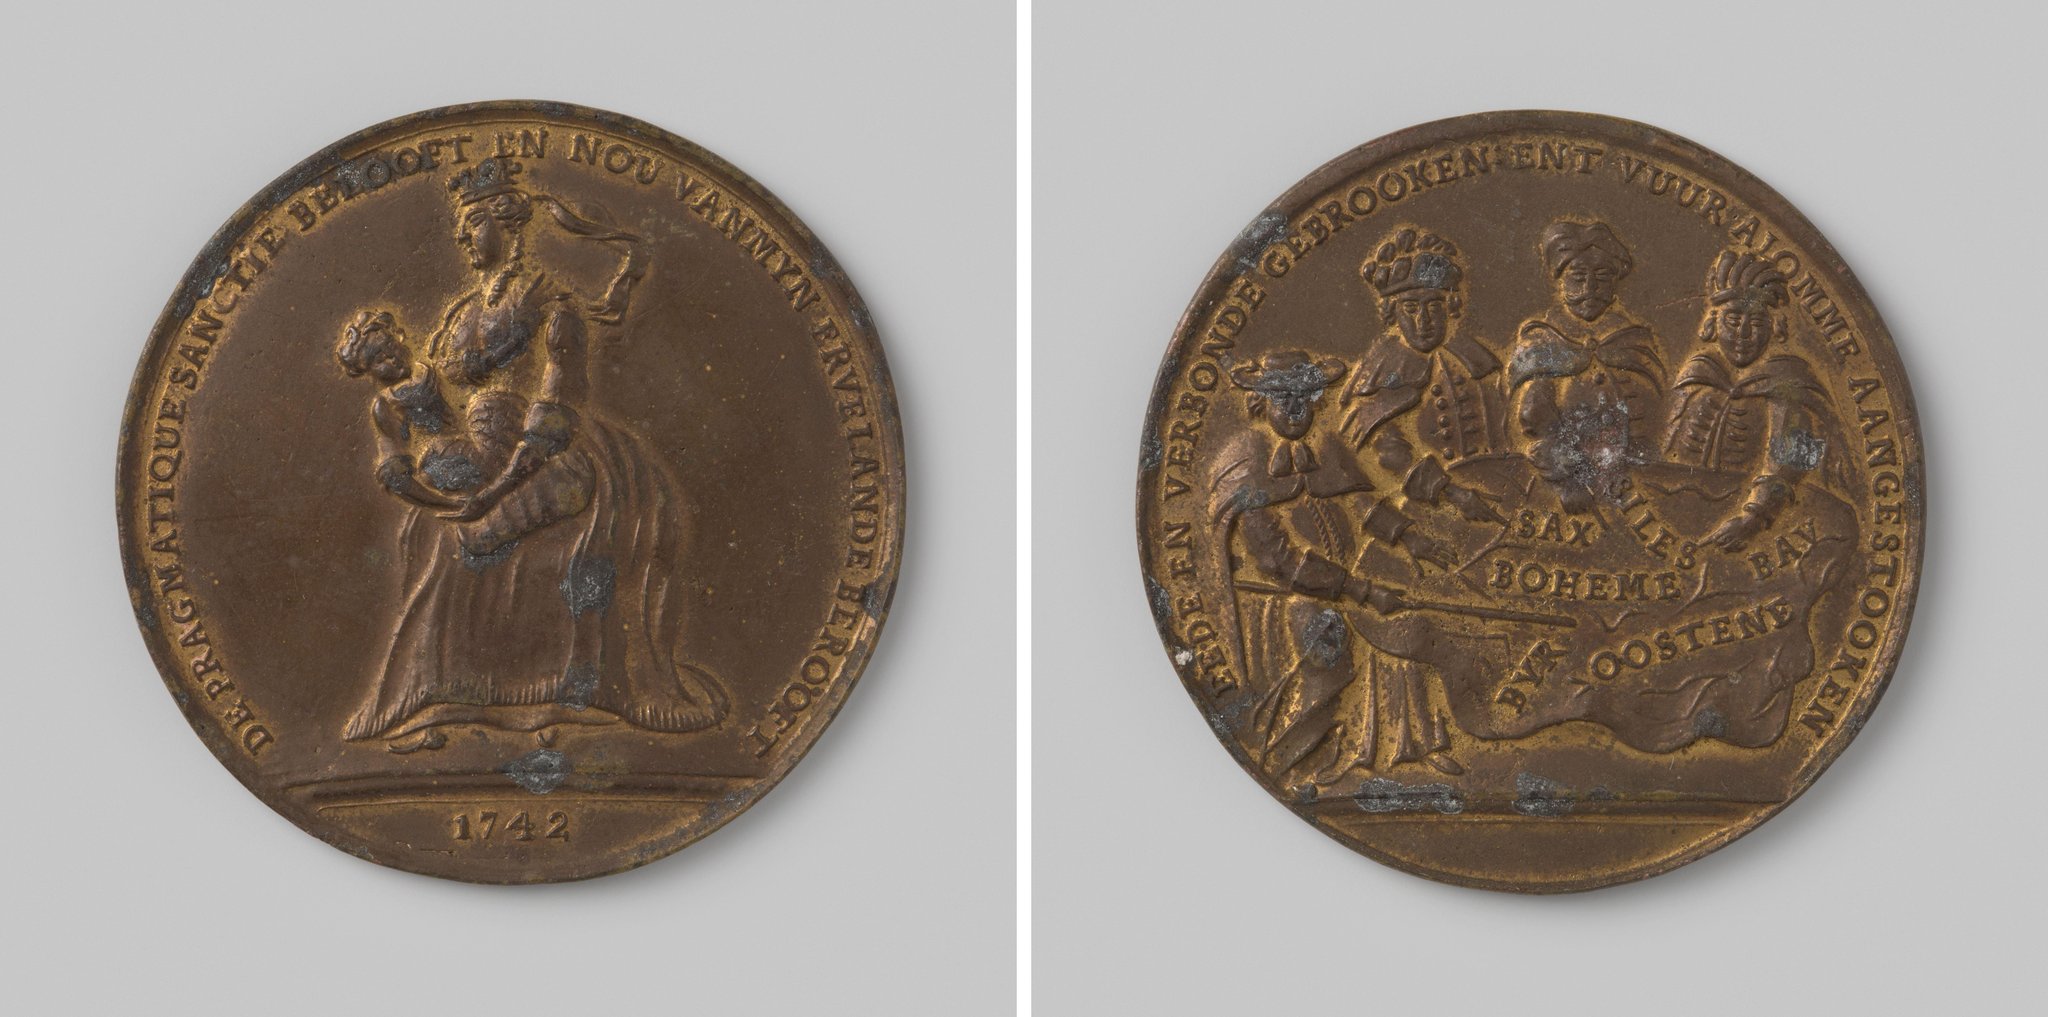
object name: history medal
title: Spotpenning op het niet naleven van de Pragmatieke Sanctie 1742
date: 1742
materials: brass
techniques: striking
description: Messing penning, op de voorzijde Maria Theresia met kind, met omschrift en afsnedetekst, op de keerzijde vier mannen rond een landkaart, met omschrift.